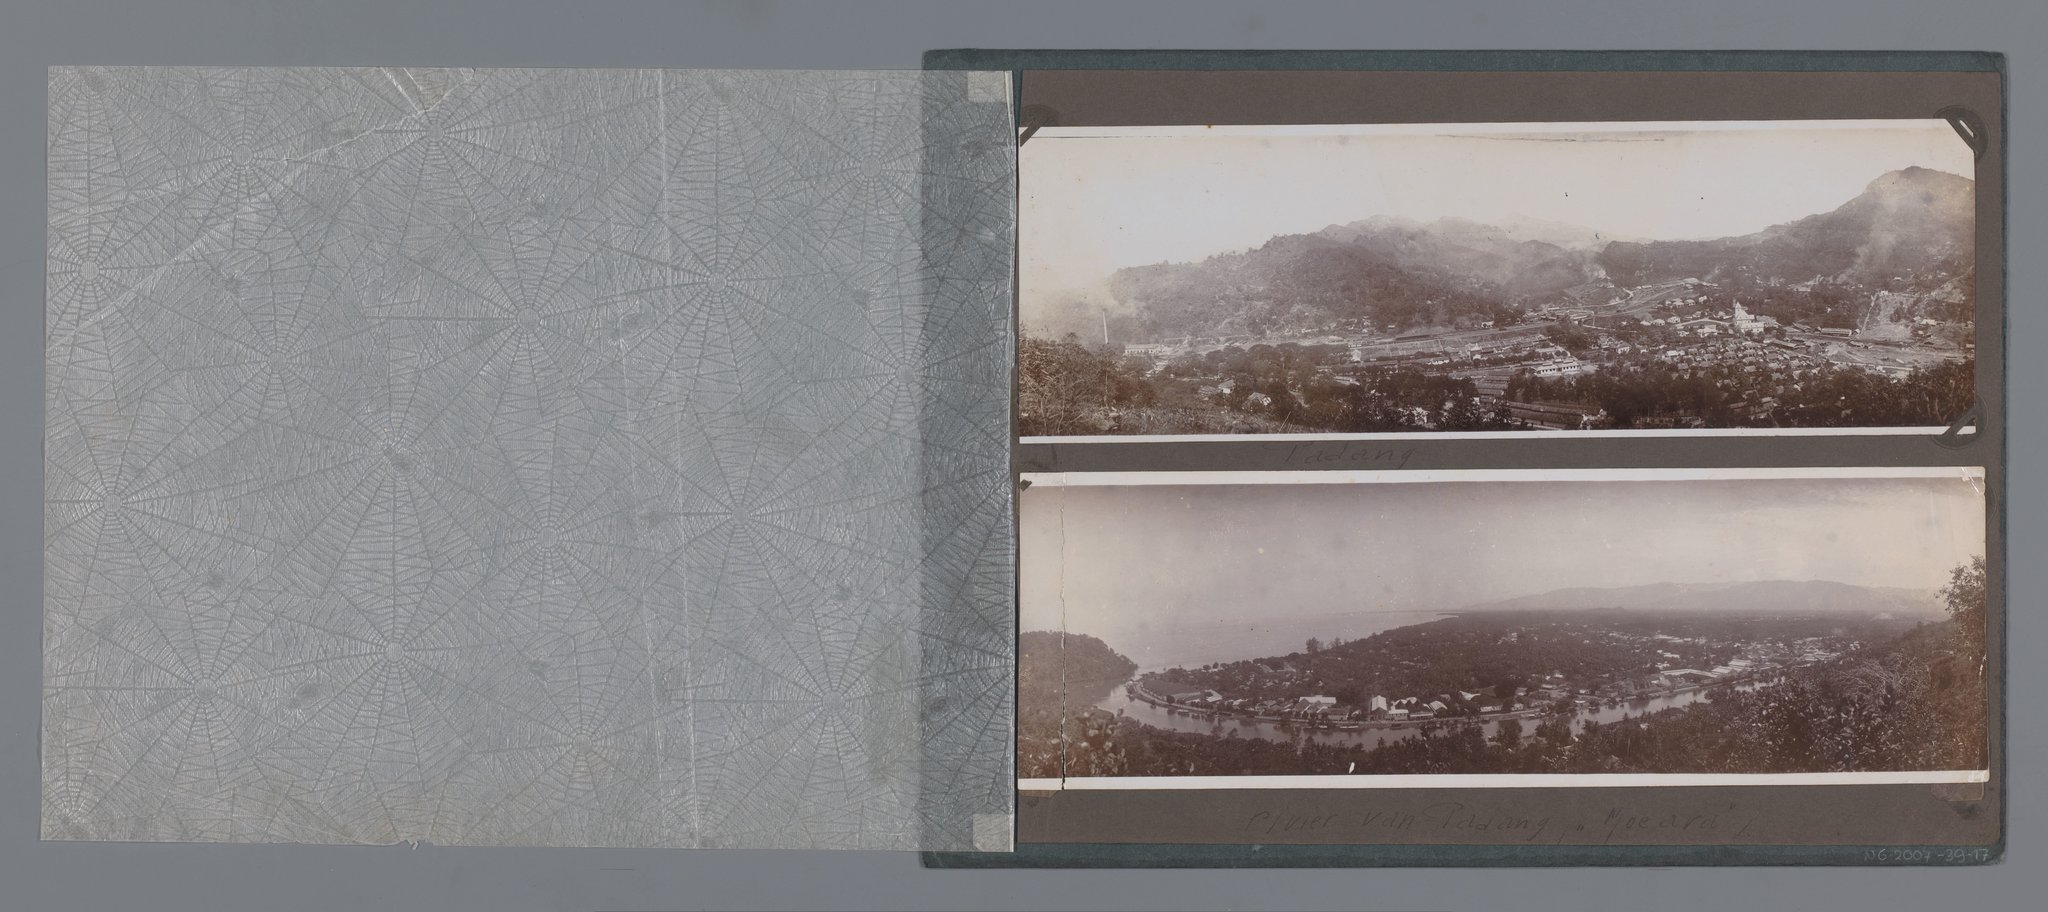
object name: photograph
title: Panorama's van Padang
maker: Anonymous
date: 1900-1939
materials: paper, photographic support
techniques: photography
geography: padang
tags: landscapes in tropical and sub-tropical regions, sumatra, dutch east indies, the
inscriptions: annotation: ‘Padang // rivier van Padang "Moeara"’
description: Padang is een grote stad op het eiland Sumatra, en één van de hoofdvestigingen van de Fraters van Tilburg in Nederlands-Indië. Op de onderste foto is de rivier die door Padang loopt aangeduid als de Moeara. De moderne naam voor deze rivier is Batang Arau.